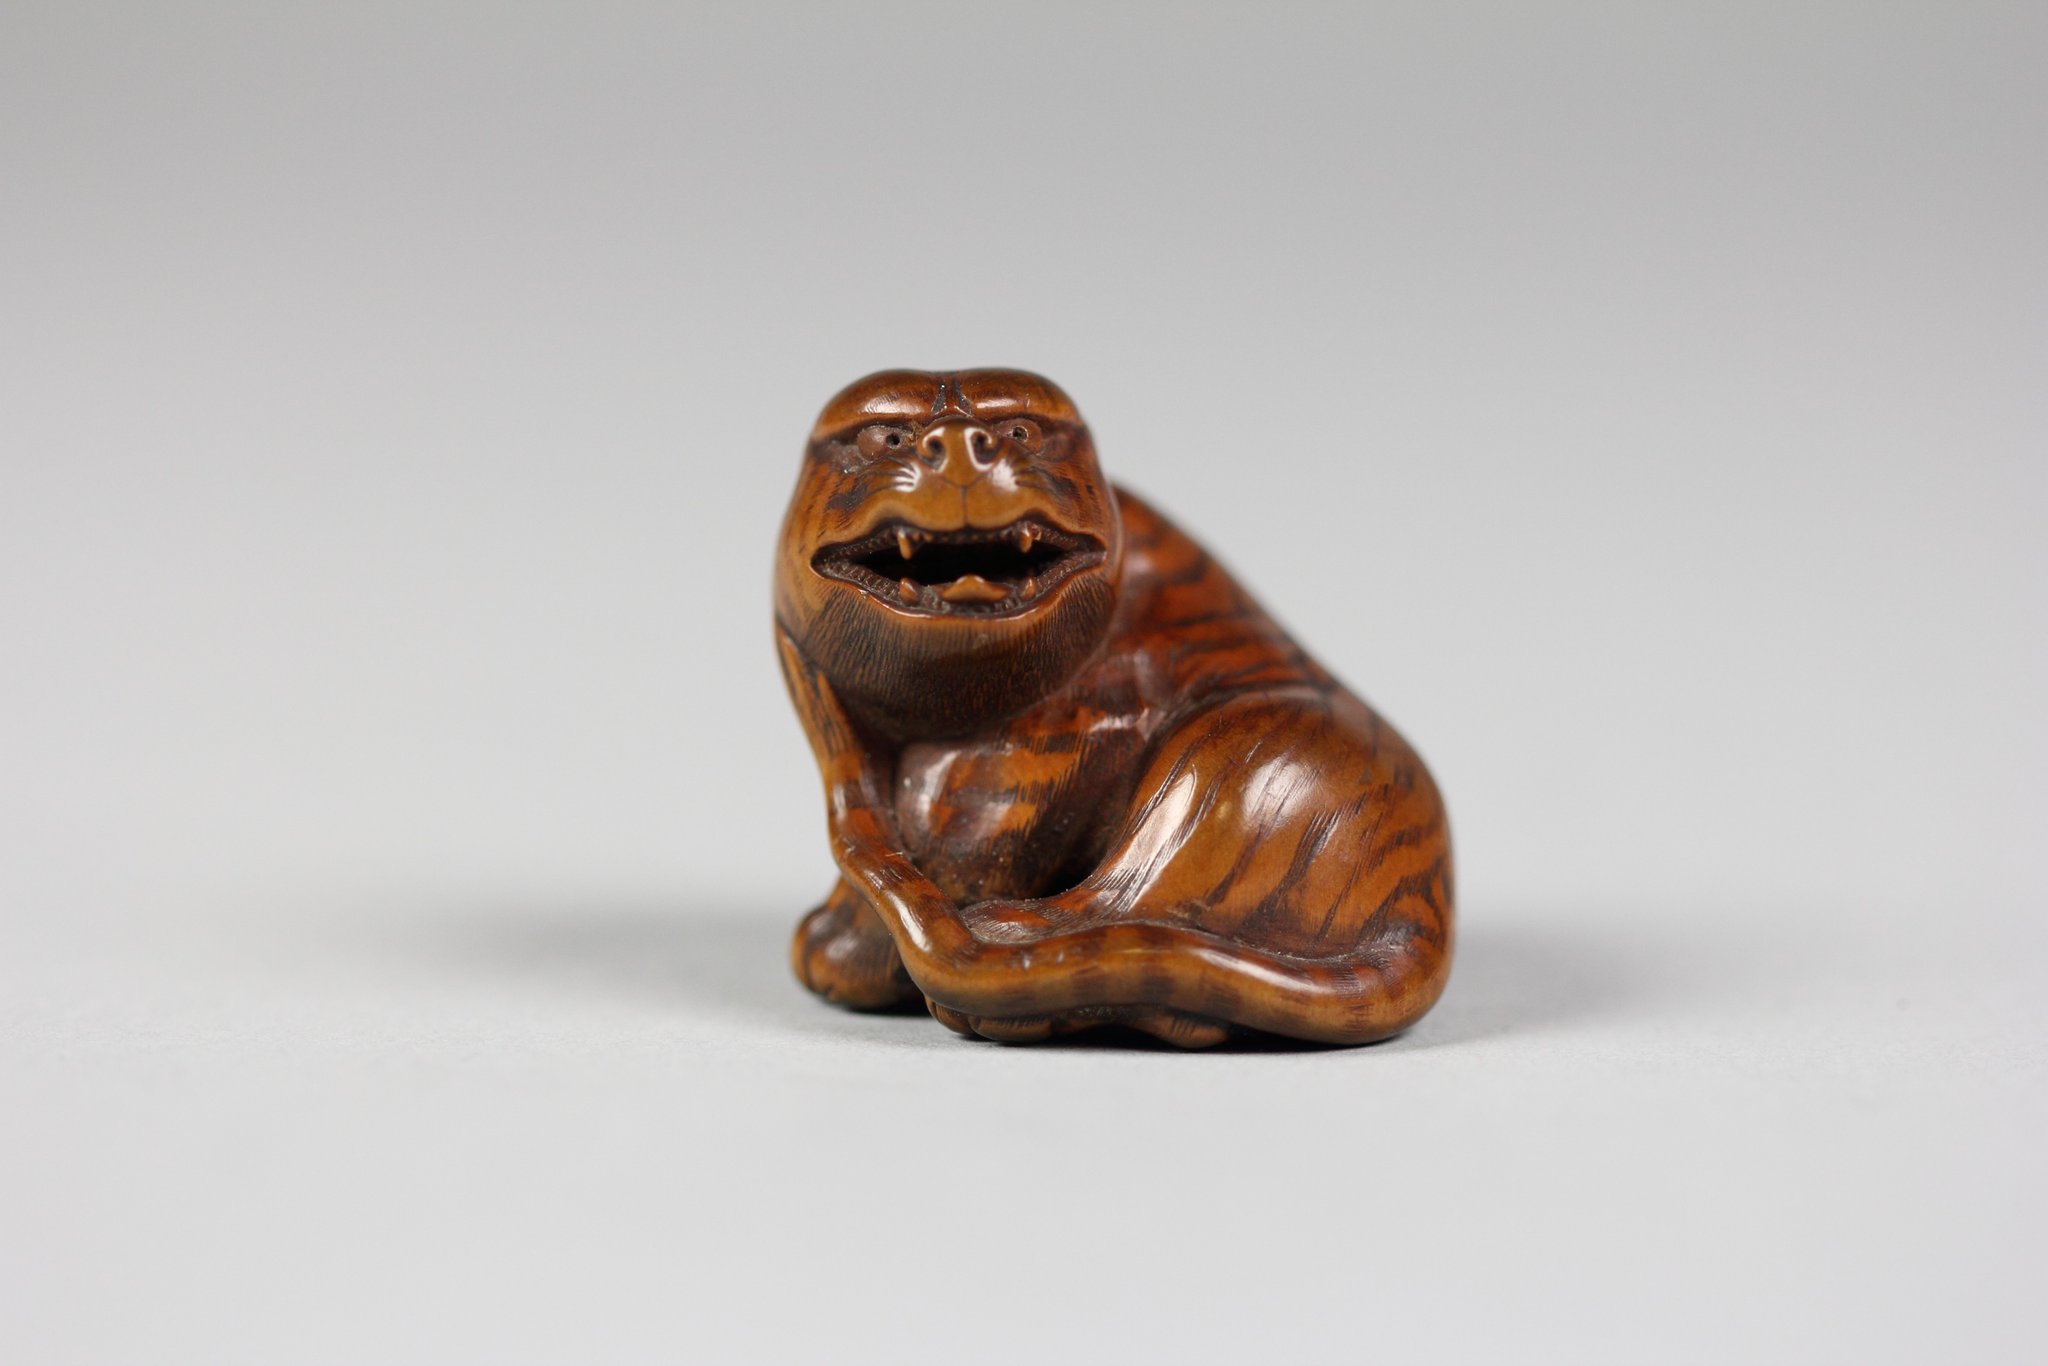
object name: netsuke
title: Netsuke of Tiger with Head Turned, Snarling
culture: japanese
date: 1701-1800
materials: wood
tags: tigers